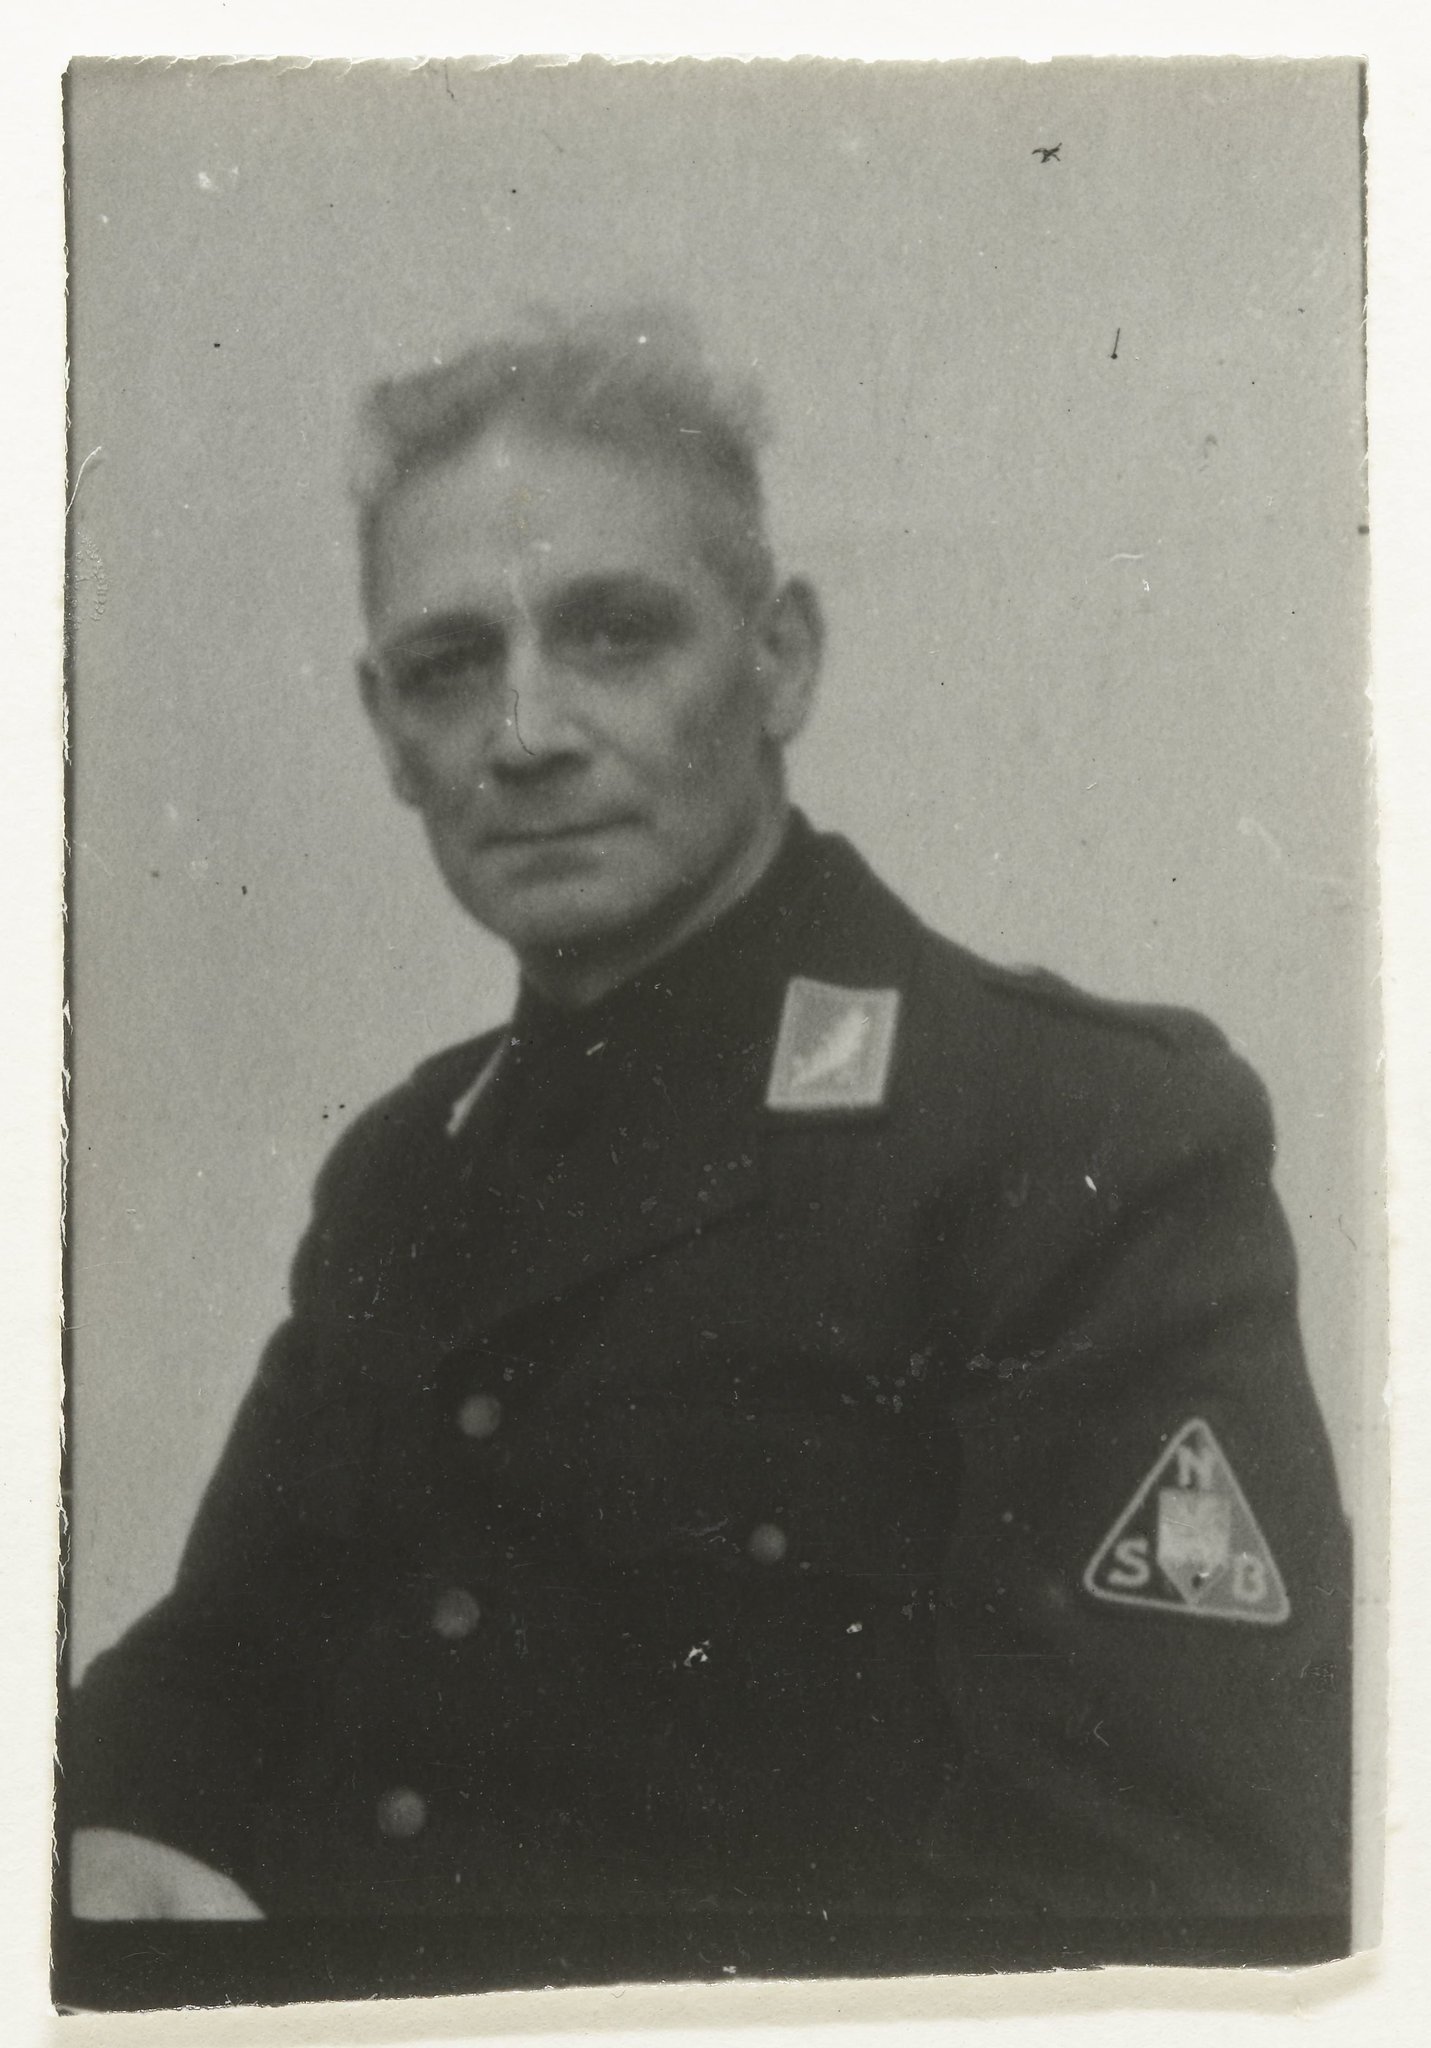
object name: contact print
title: Portret van een lid van de NSB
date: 1940-1944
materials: photographic support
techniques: photography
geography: netherlands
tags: anonymous historical person portrayed, netherlands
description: Portret van een lid van de NSB. Op zijn kraag een distinctief van een blad met nerven, functie bij het Hoofdkwartier van de NSB, Hoofd van Afdeeling? Op zijn linkermouw driehoekige NSB embleem. Oudere man, blootshoofd.